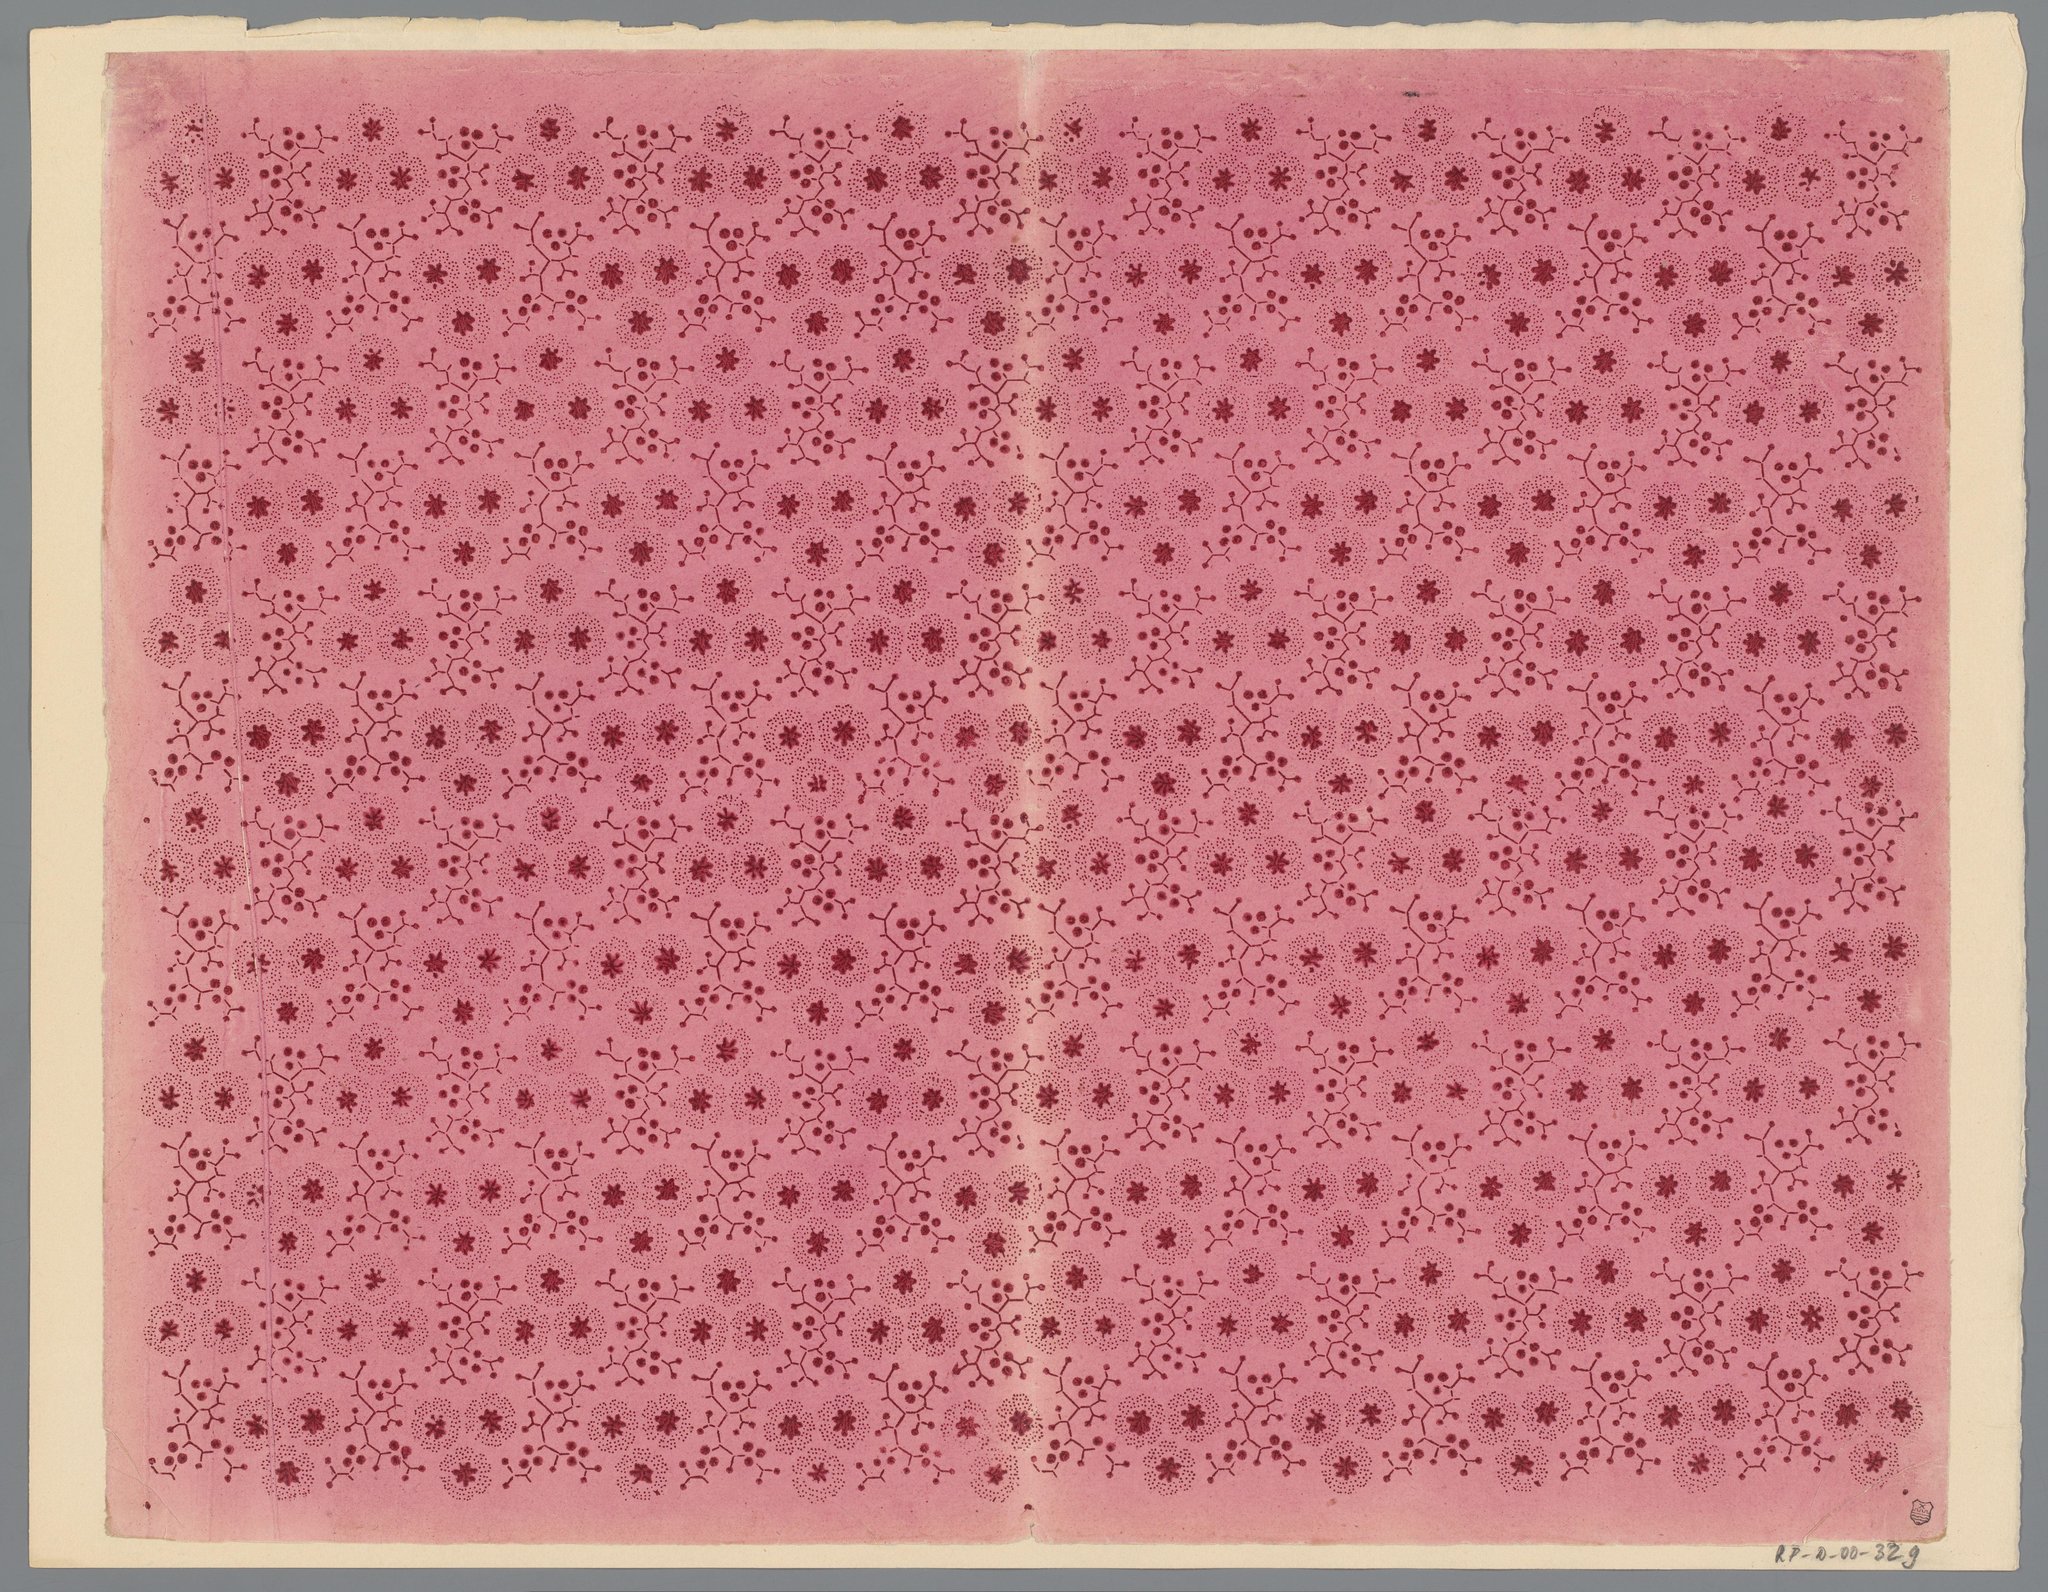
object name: wrapper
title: Blad met strooipatroon van bloemmotief omgeven door takjes met vruchtjes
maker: Anonymous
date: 1750-1950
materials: lacquer, paper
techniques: printing block, lacquer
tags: ornament derived from plant forms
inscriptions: collector's mark: Lugt 2760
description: Blad met strooipatroon van bloemmotief omgeven door takjes met vruchtjes. Gebruikt als omslag.